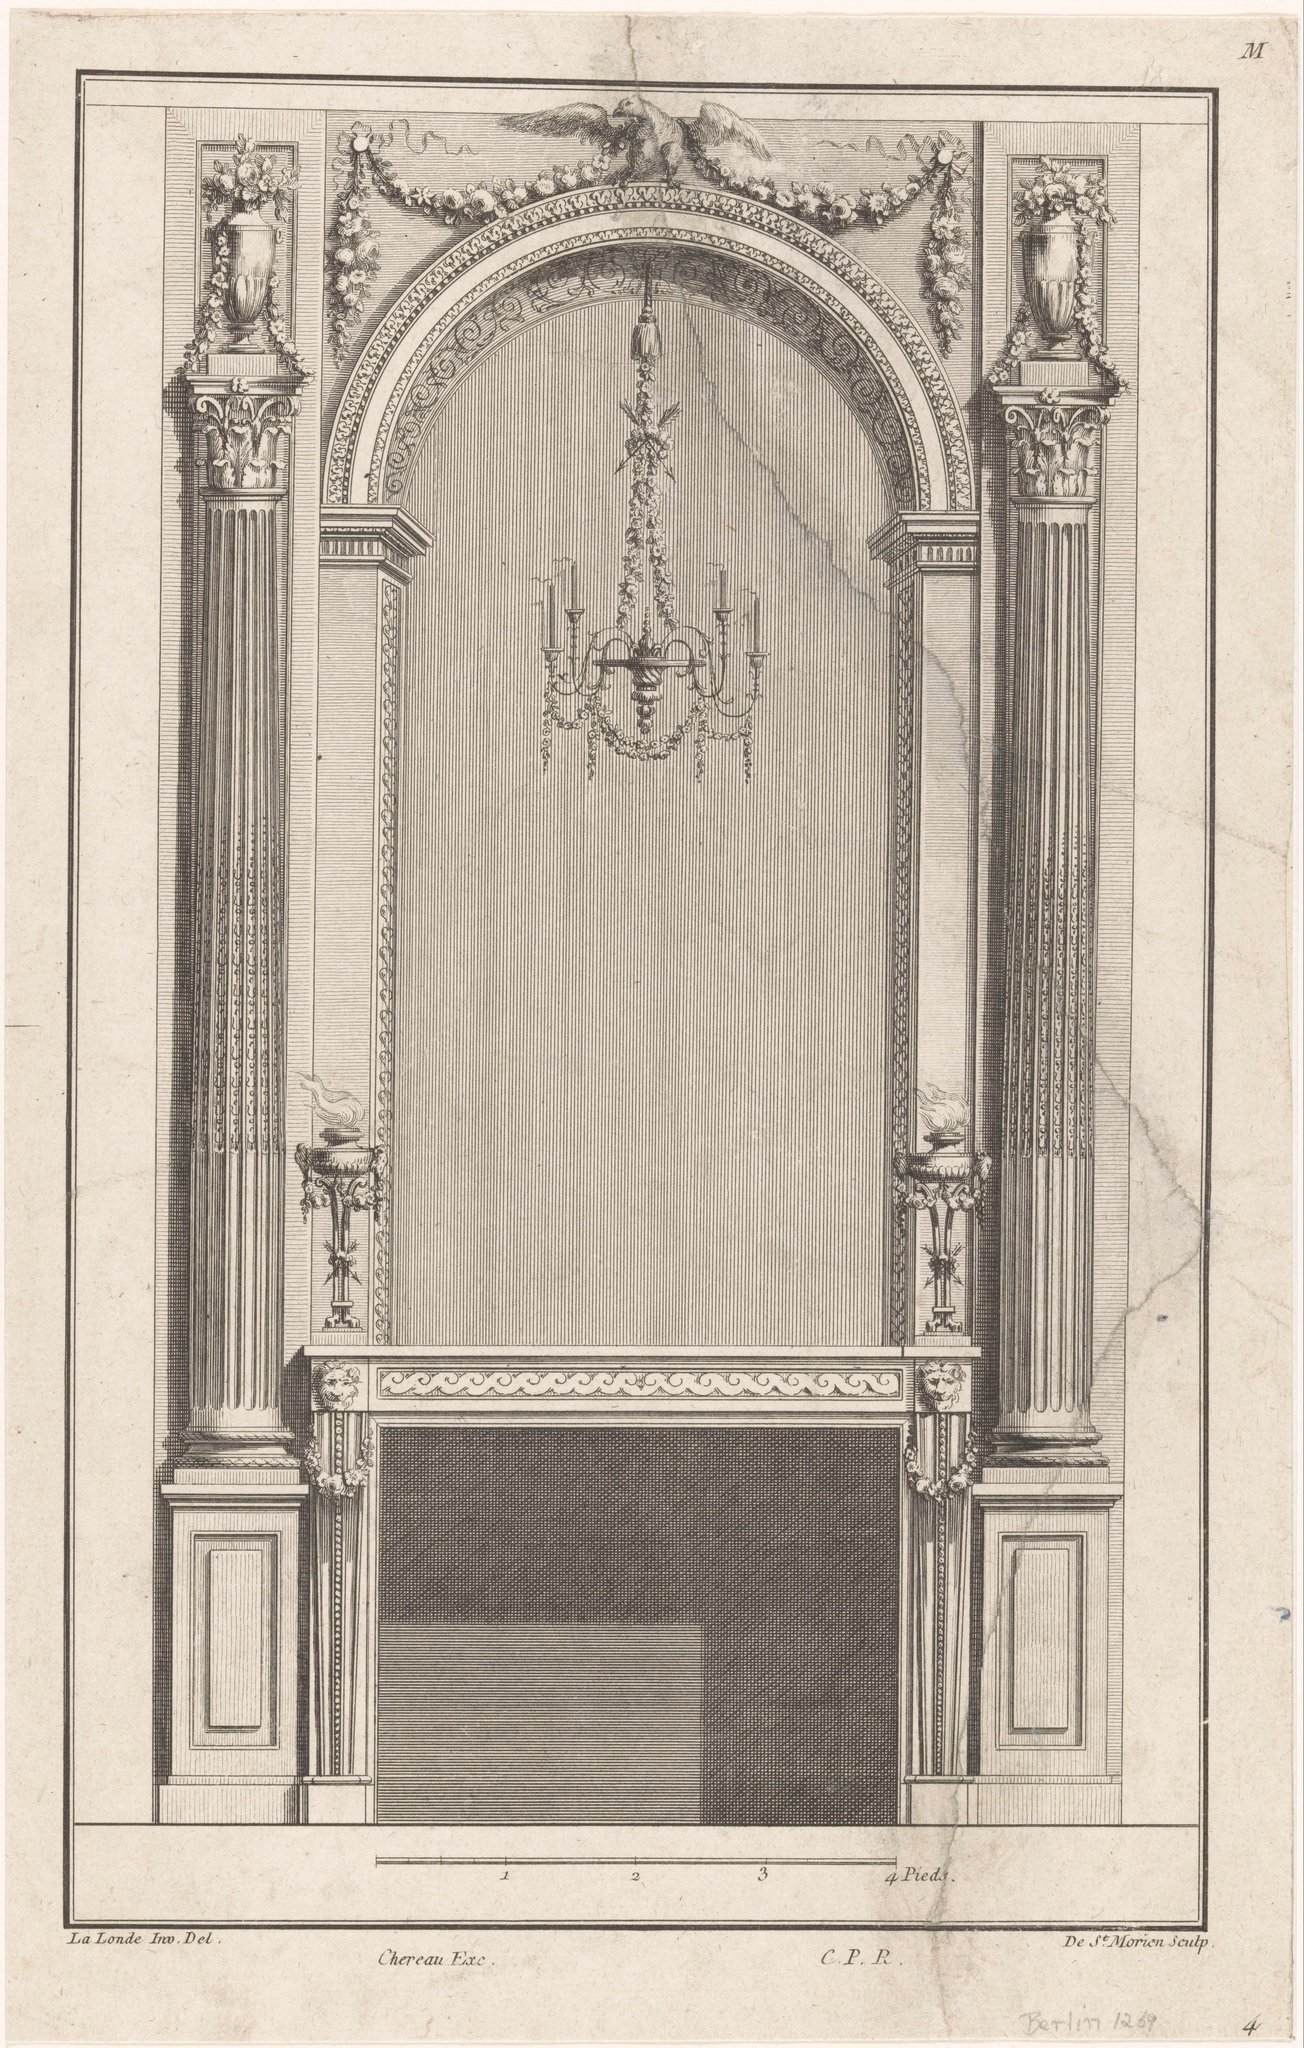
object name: print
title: XIIe Cahier de l'Oeuvre M Cheminées avec leurs Trumeaux &c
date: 1784-1785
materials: paper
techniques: engraving, etching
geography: paris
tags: chandelier, candelabrum, open hearth, fire-place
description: Een geornamenteerde schouw met een vierarmige kroonluchter. Aan de bovenzijde een vogel met guirlandes. Aan weerszijden van de schouw twee rookvaten en Korinthische zuilen met vazen met bloemen.